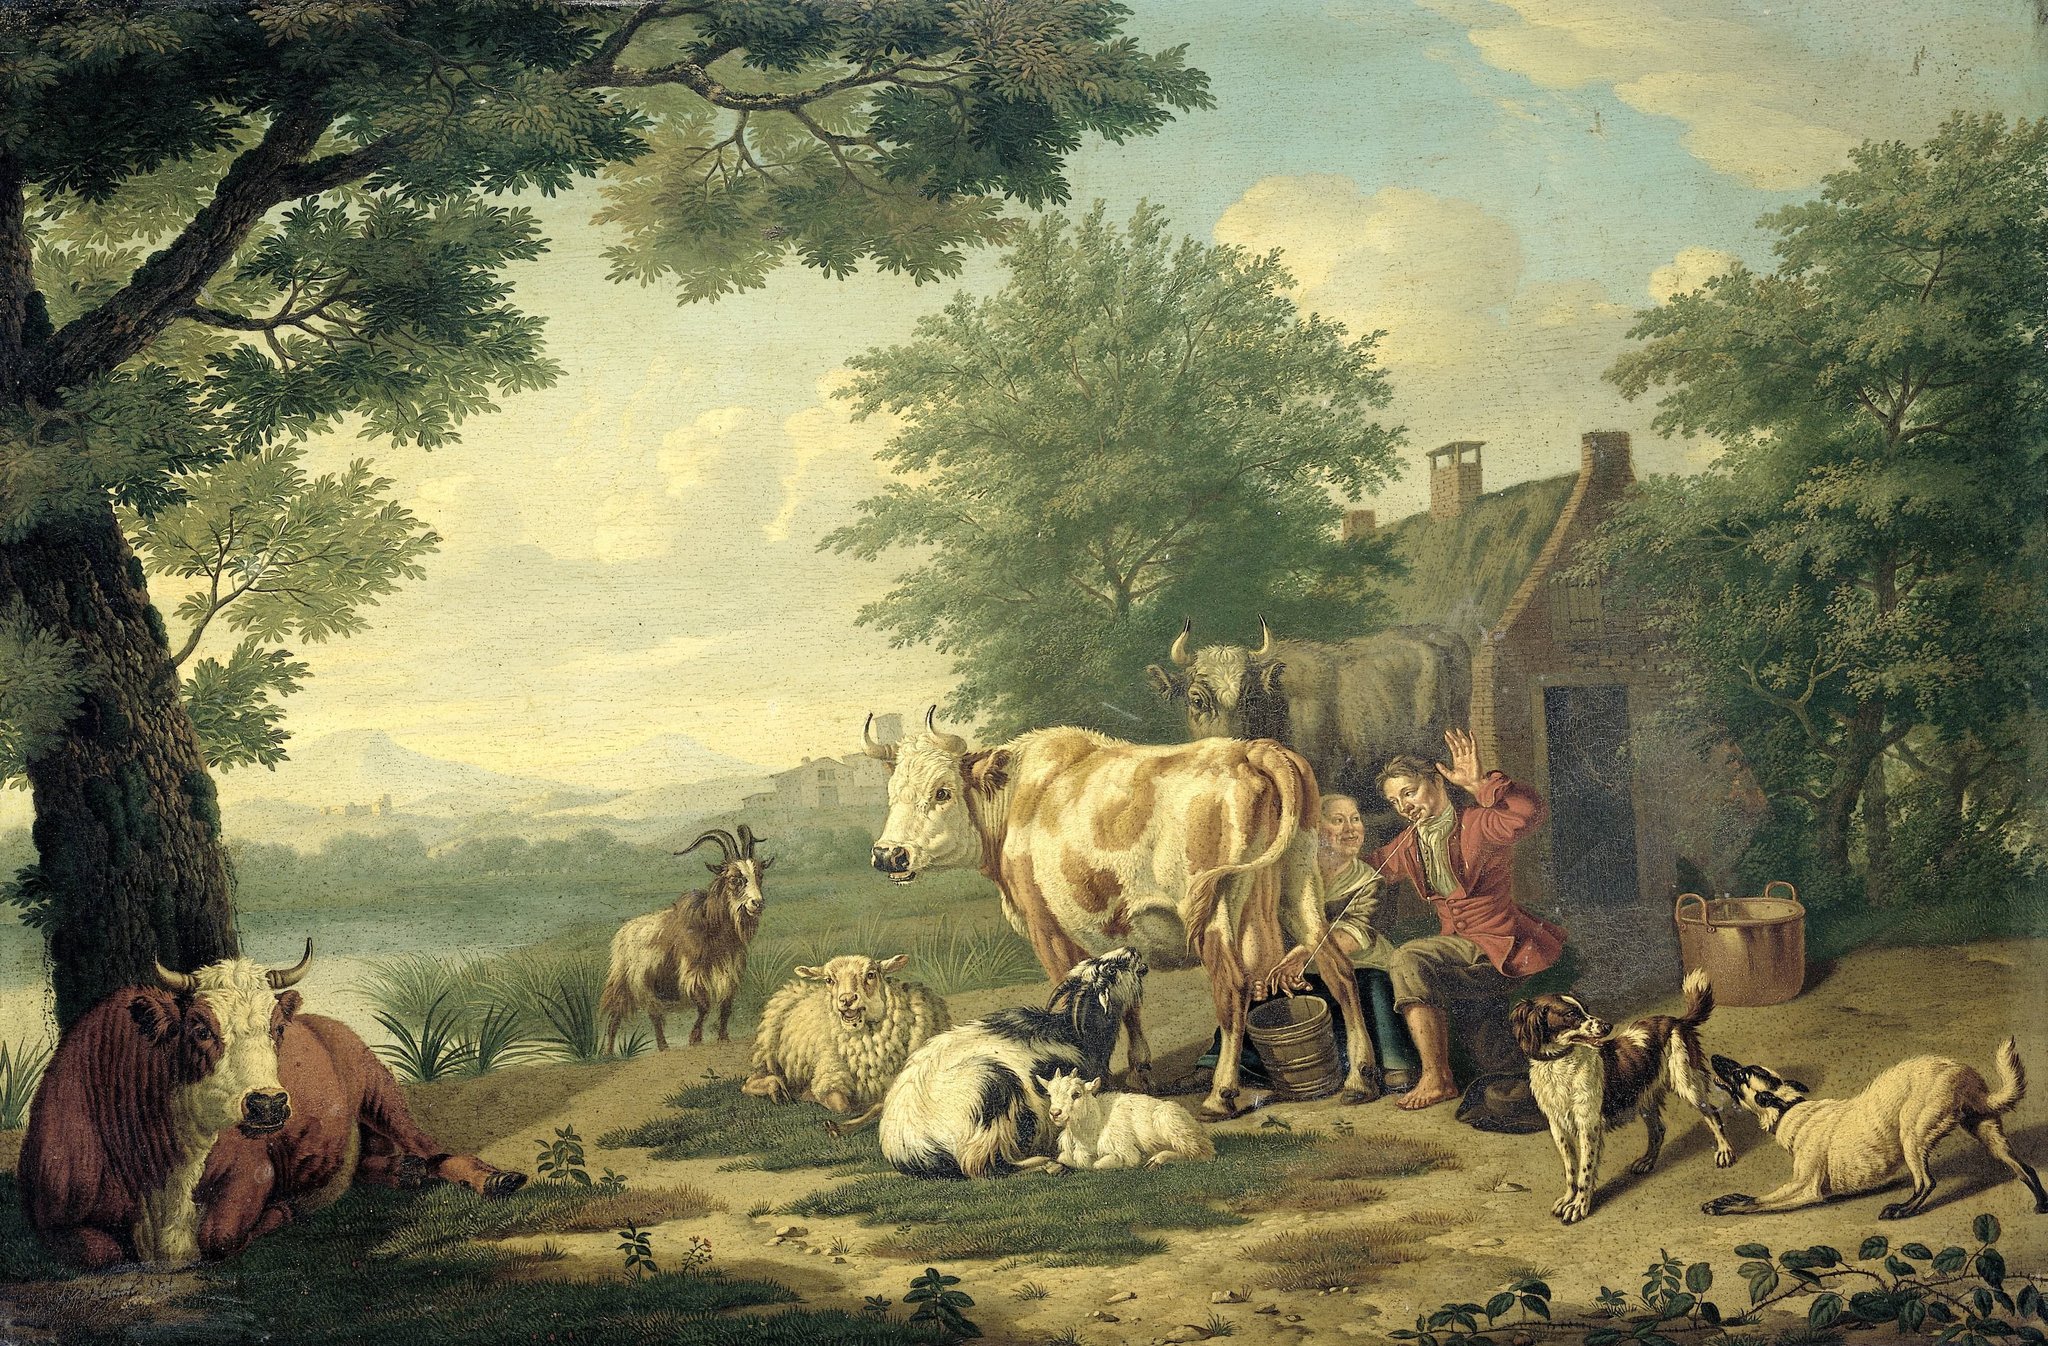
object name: painting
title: Milking Time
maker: jan van gool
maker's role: draughtsman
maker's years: 1685-1763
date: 1710-1763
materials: oil, panel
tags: milkmaid, milking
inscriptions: signature: ‘J. v. Gool ft’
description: Het melkuur. Op het erf voor een boerderij spuit een melkmeid speels melk in het gezicht van de man die naast haar zit. Om de figuren meer vee (koe, schaap, geit) en twee spelende honden. Landschap met links in de verte een meer en bergen.